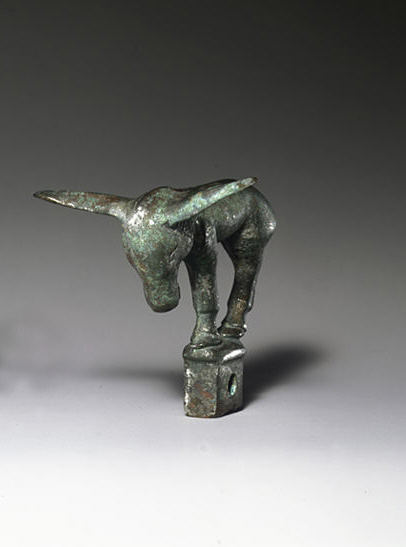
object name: finial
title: Finial in the Shape of Kulan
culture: chinese or mongolian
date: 400-301 BCE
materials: bronze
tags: animals